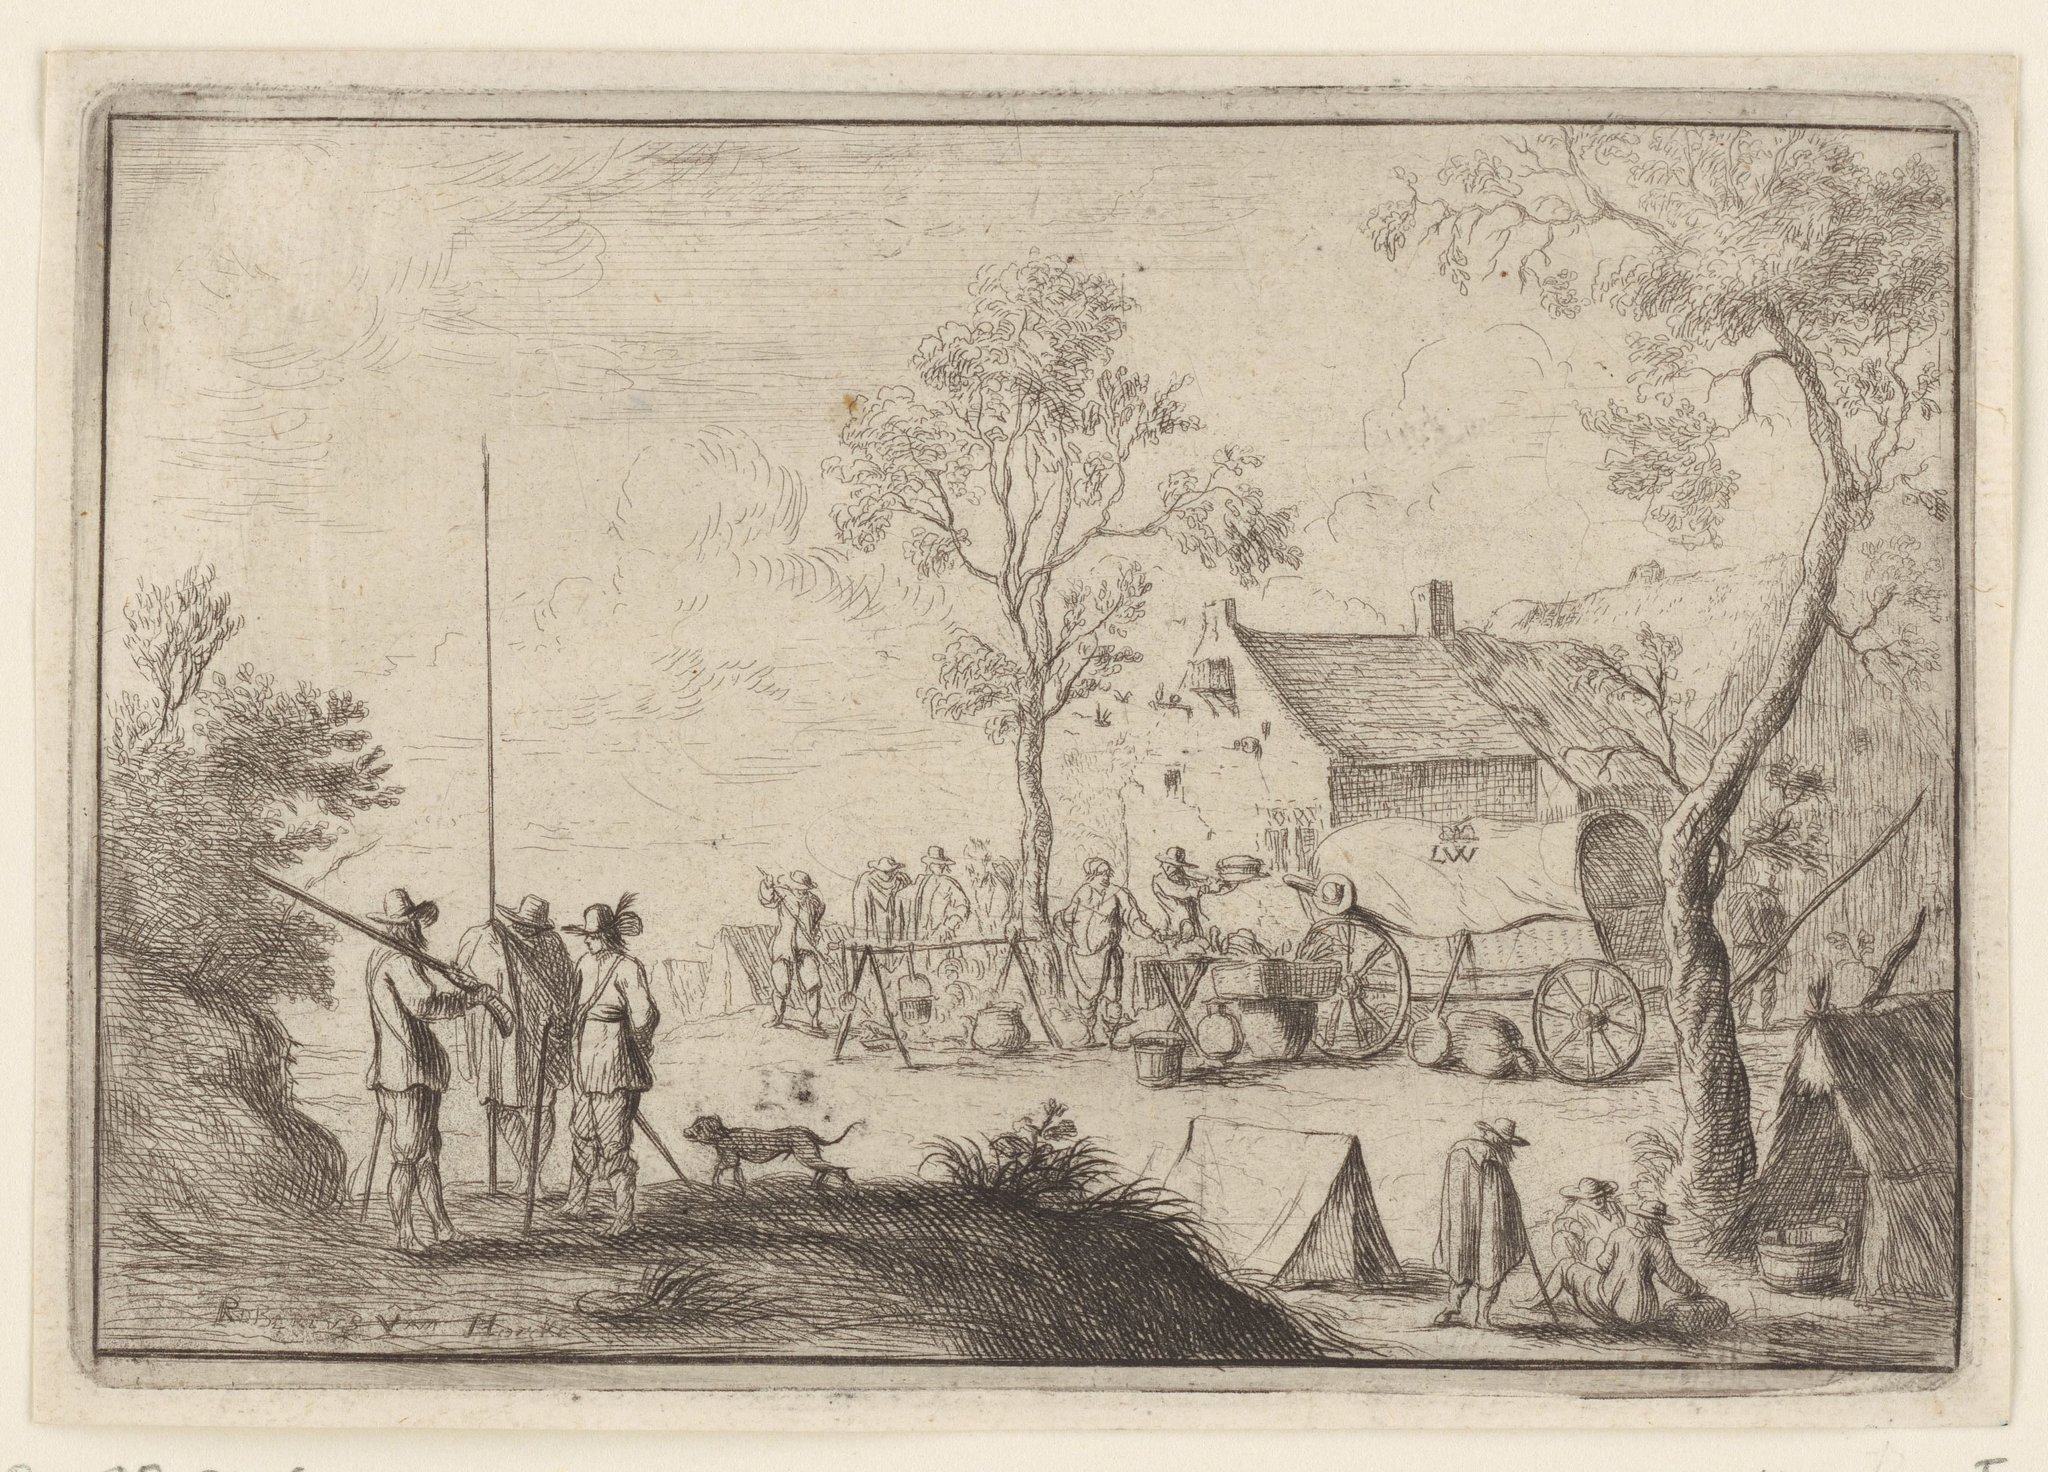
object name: print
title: Soldaten rond een kookpot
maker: robert van den hoecke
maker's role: draughtsman, painter, print maker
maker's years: 1622-1668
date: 1632-1668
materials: paper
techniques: etching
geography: southern netherlands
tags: covered wagon, hooded wagon, cooking food - cc - in the open air, tent-camp, the soldier; the soldier's life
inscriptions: collector's mark: Lugt 240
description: Soldaten rond een kookpot bij een huifkar voor een huis. Op de voorgrond een groep converserende soldaten met een hond.